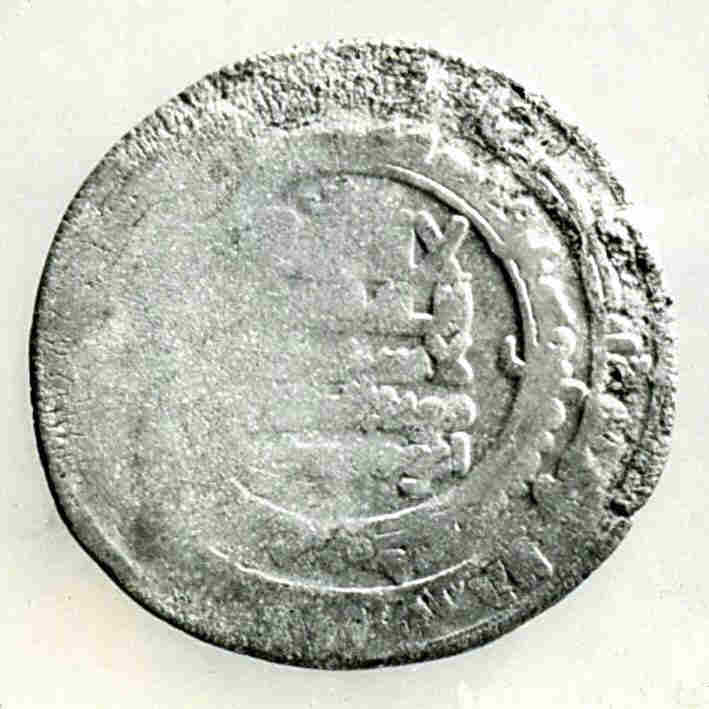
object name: coin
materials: silver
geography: iran